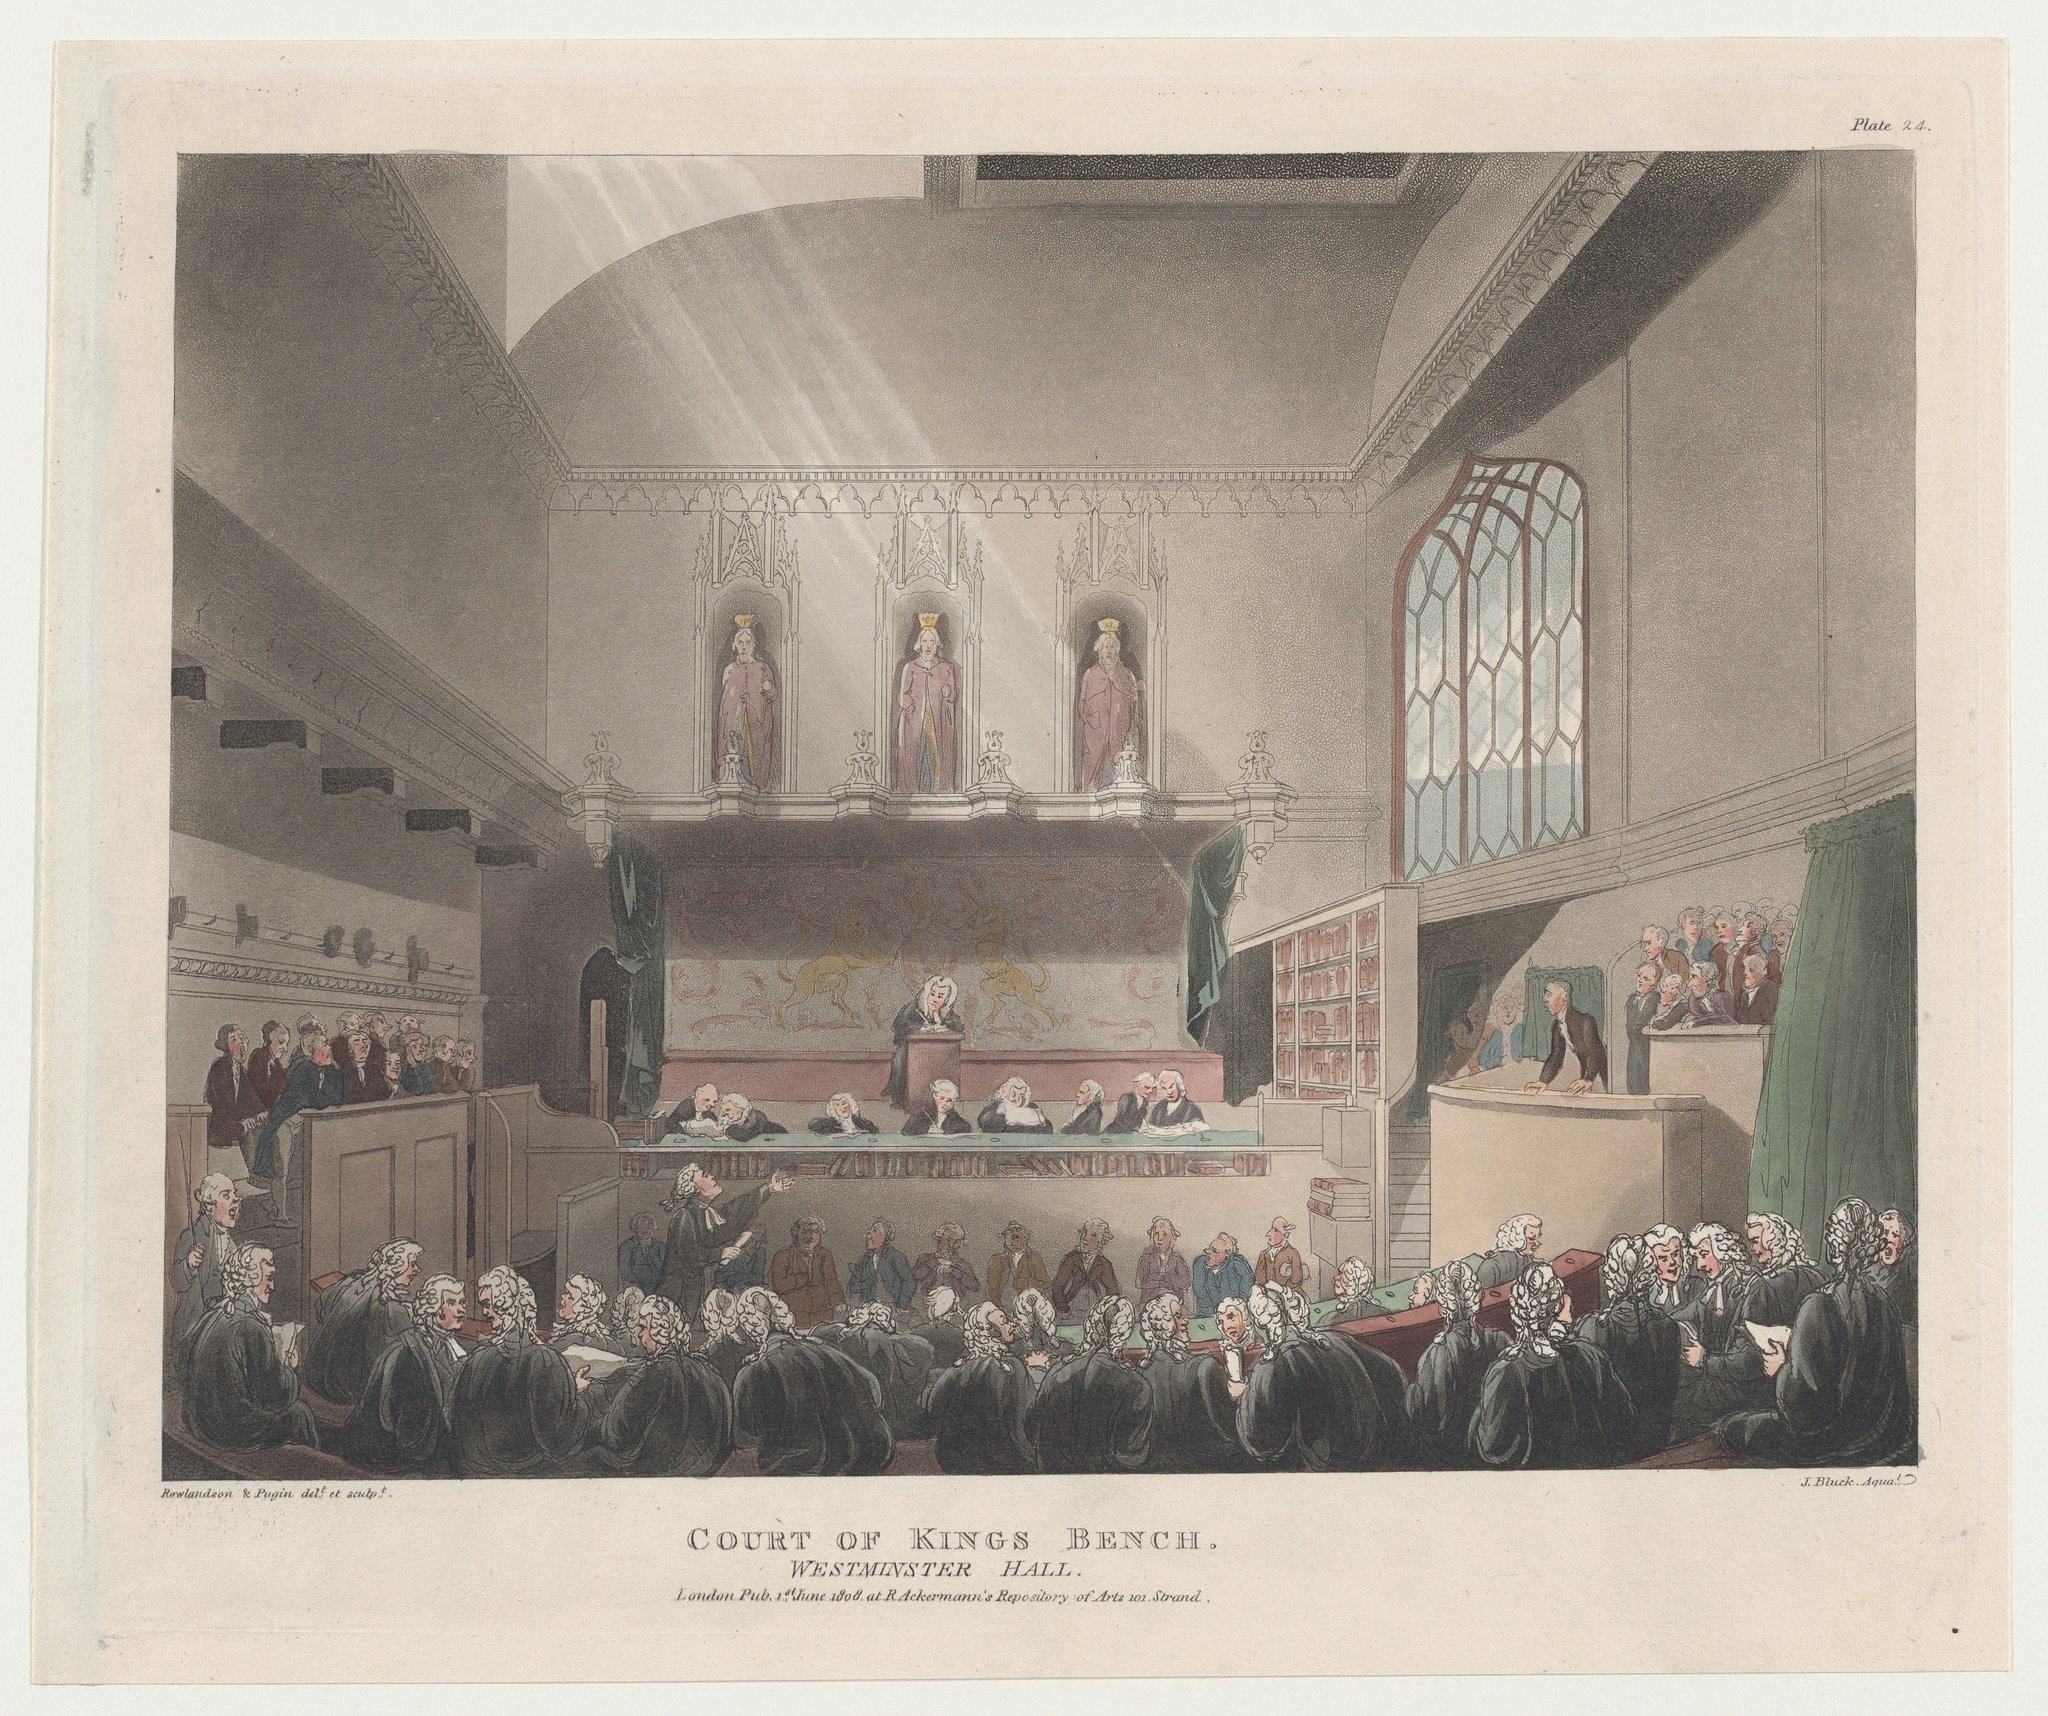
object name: print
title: Court of Kings Bench, Westminster Hall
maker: thomas rowlandson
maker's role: artist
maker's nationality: british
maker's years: 1757-1827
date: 1808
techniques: aquatint, etching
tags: men